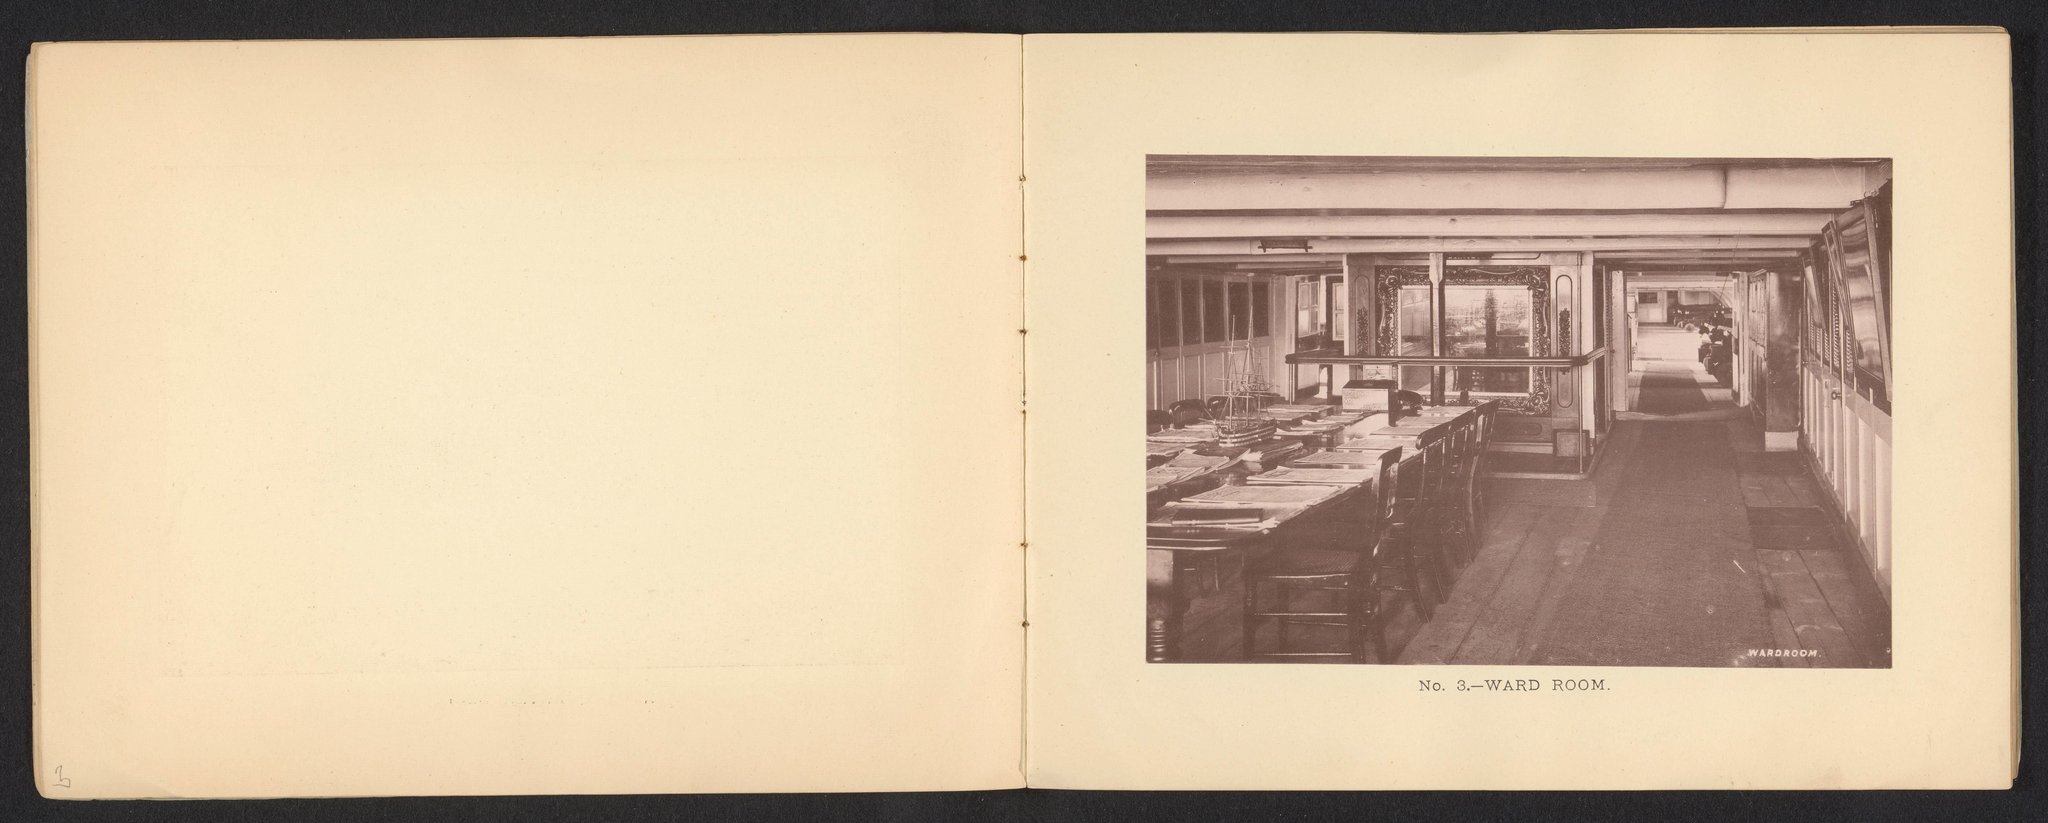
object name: page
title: Wardroom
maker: Anonymous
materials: paper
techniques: photograph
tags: parts of ship's interior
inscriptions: number: ‘No. 3.’